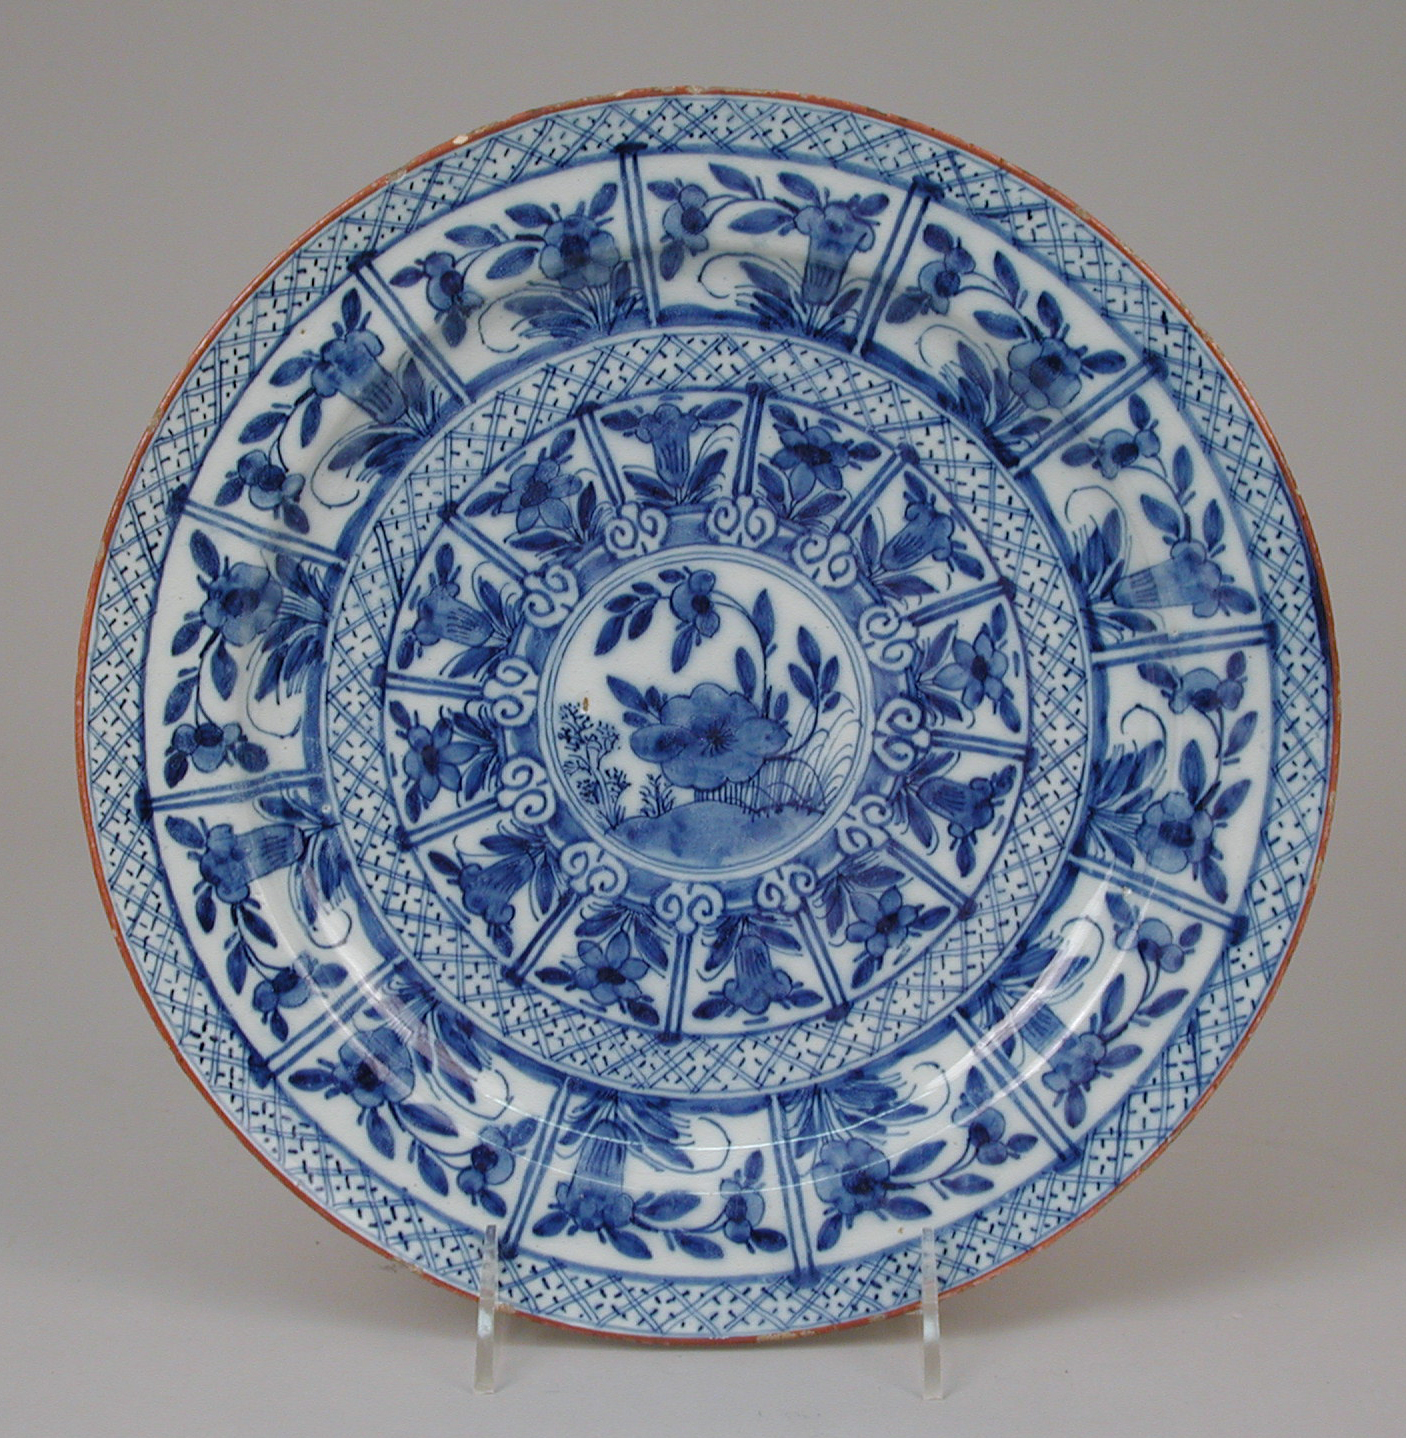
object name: plate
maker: the "greek a" factory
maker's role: manufactory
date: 1722-1757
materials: earthenware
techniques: glazing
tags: flowers